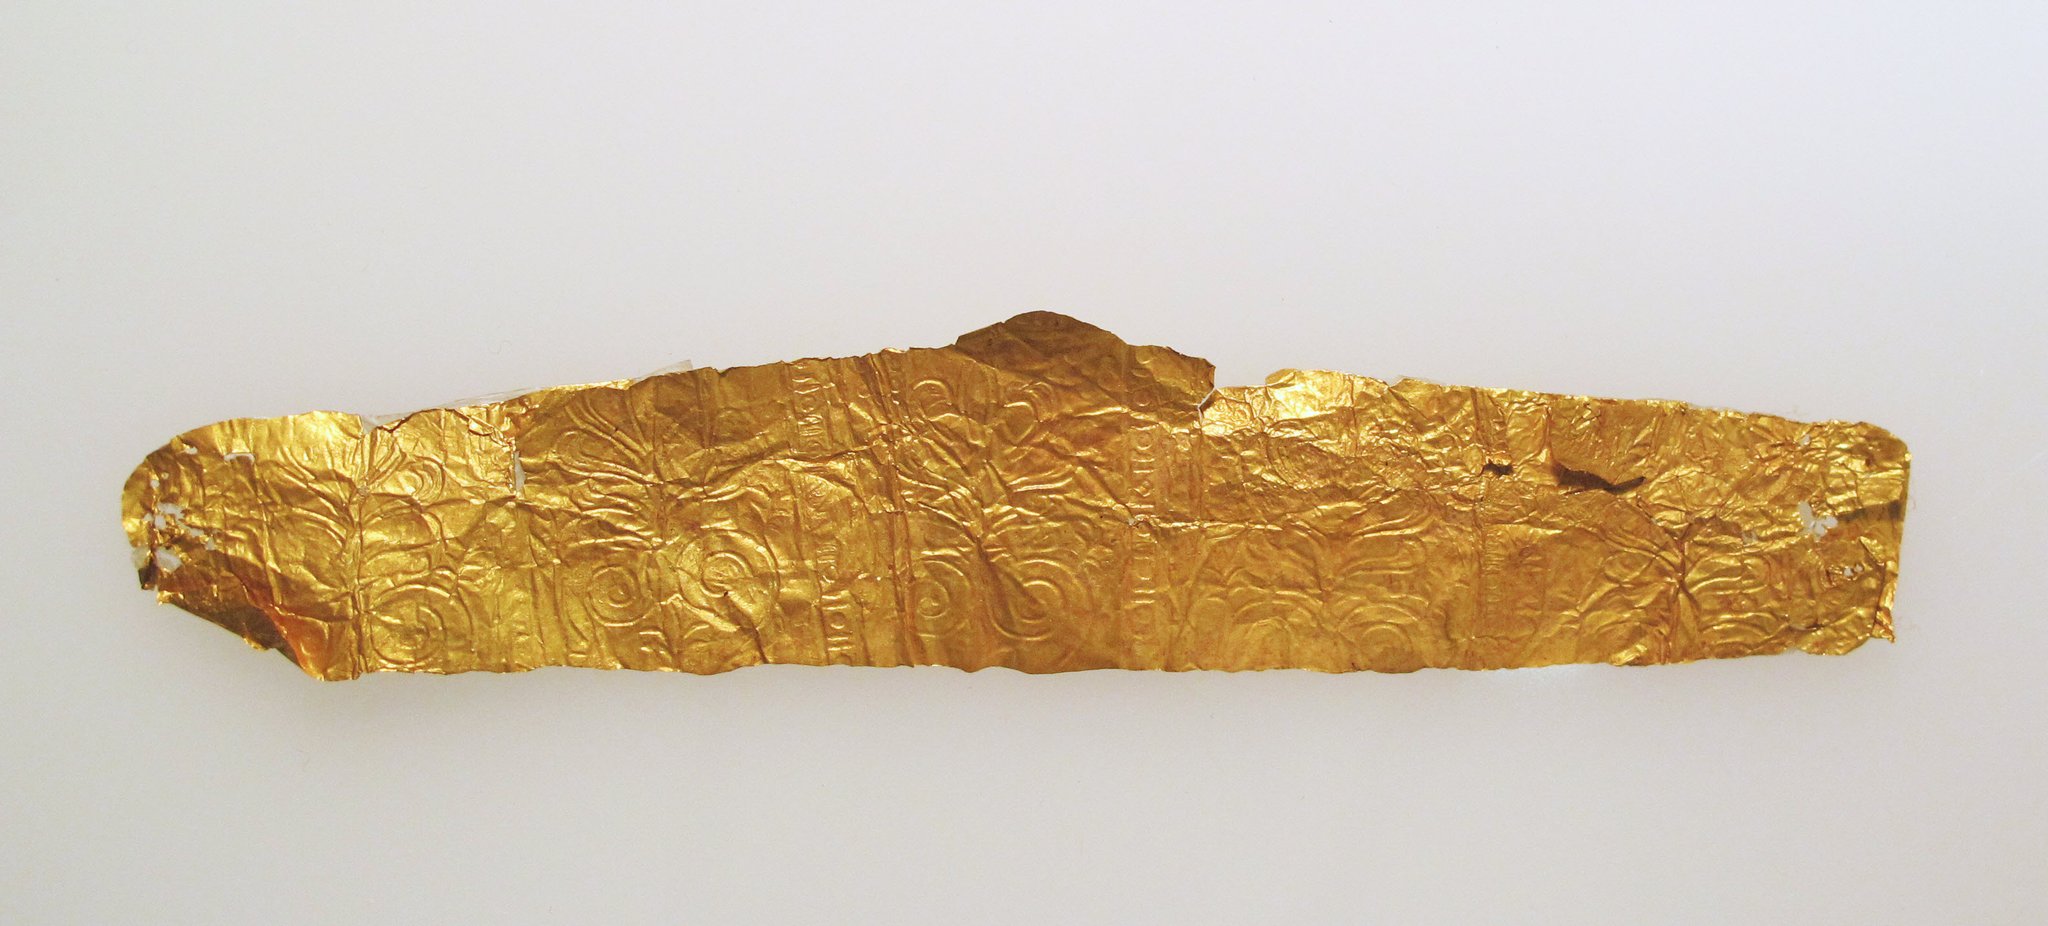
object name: frontlet of gold leaf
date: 7000 BCE-330 CE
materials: gold